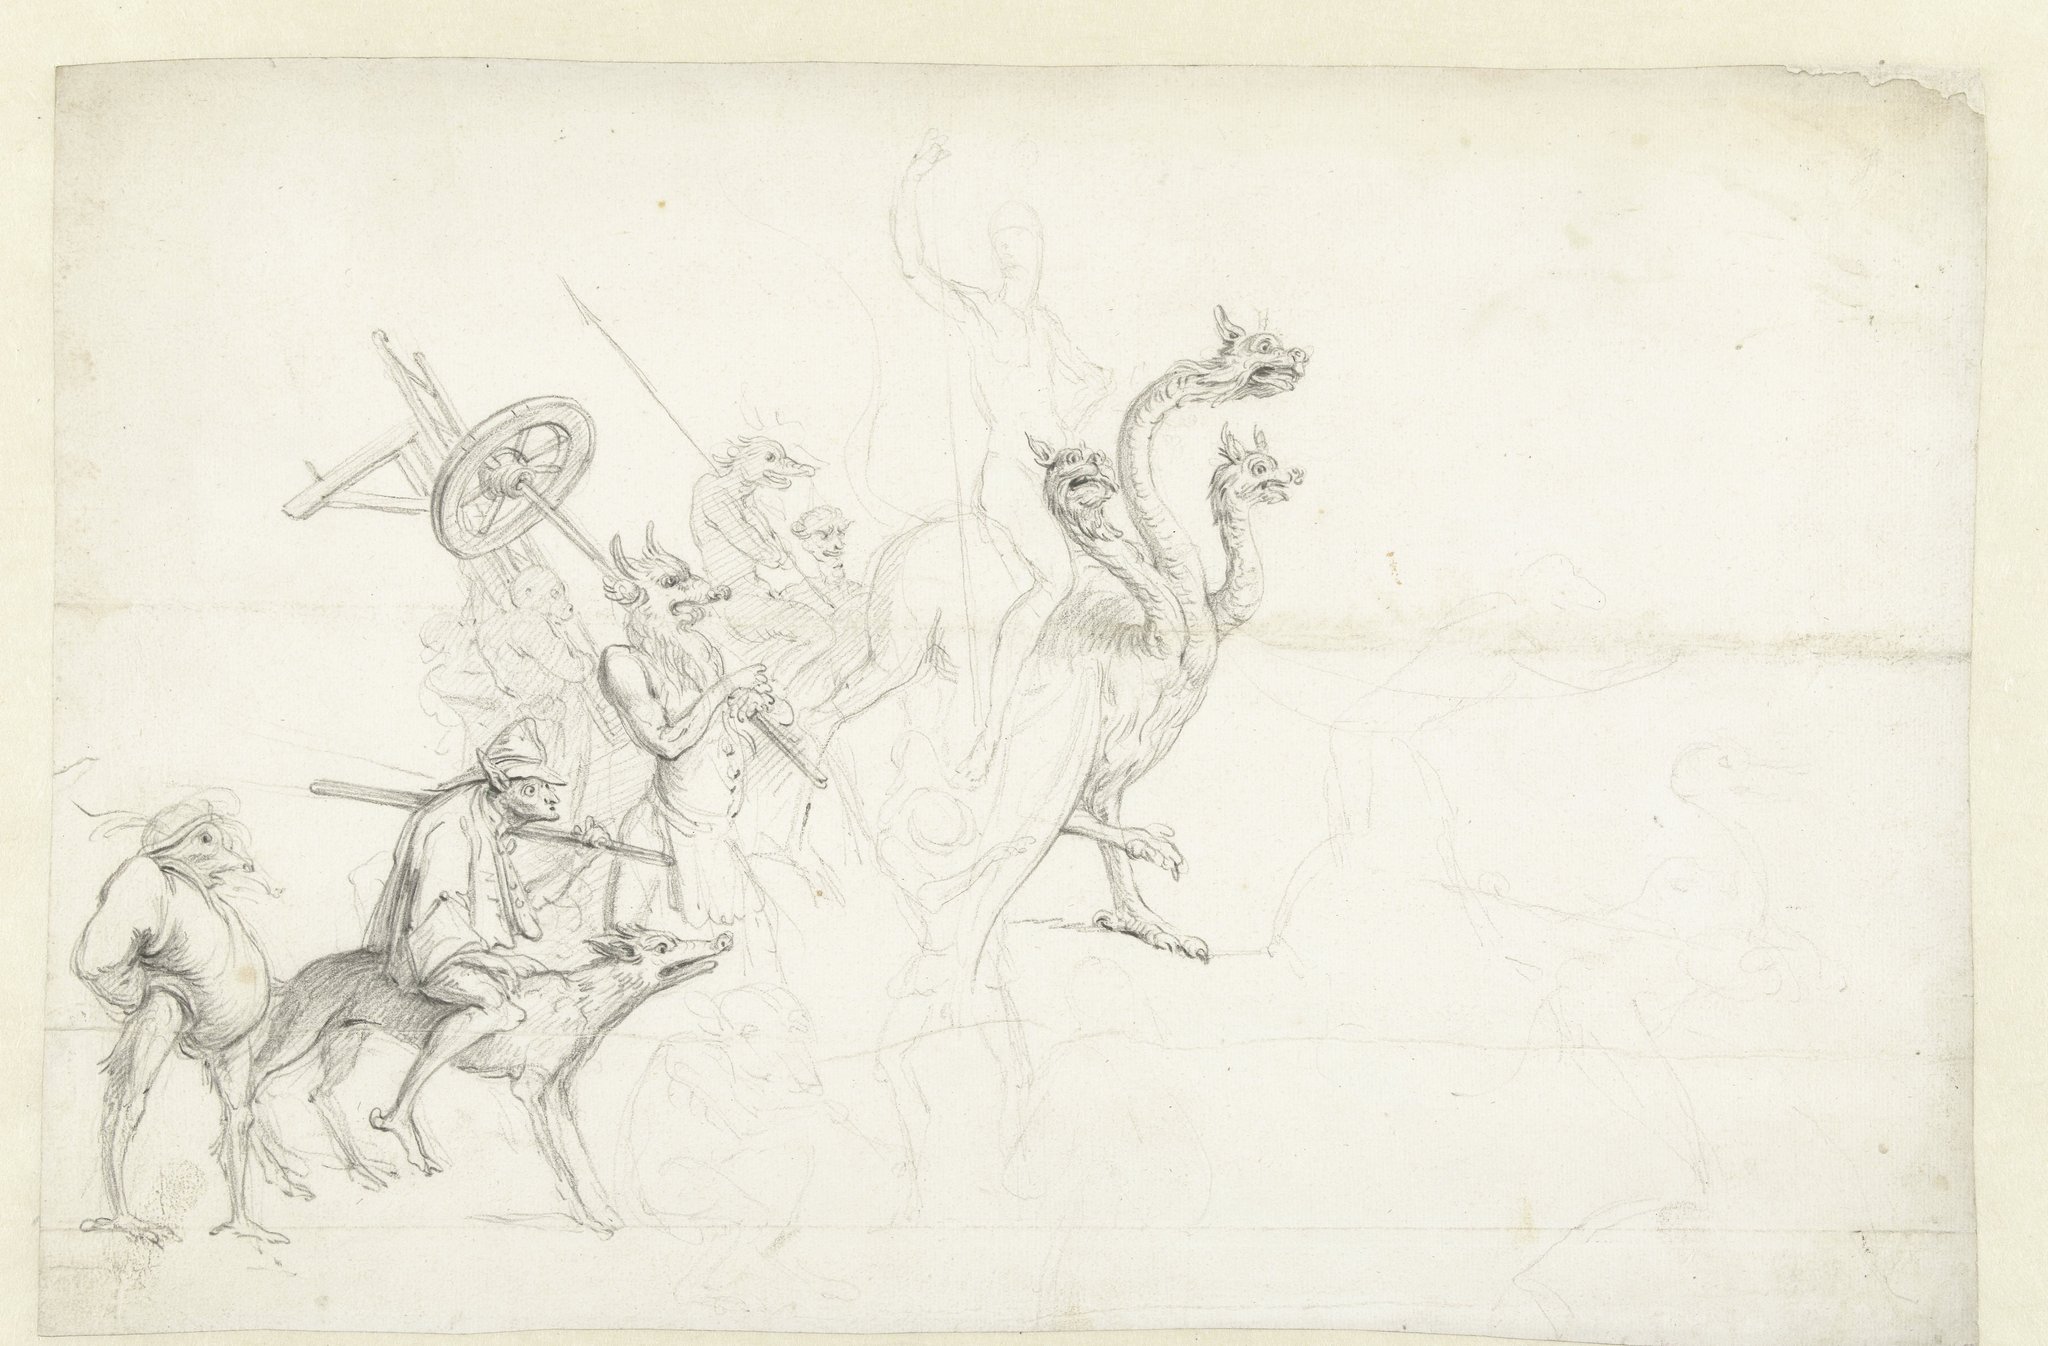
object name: drawing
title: Group of Imaginary Creatures, Turned to the Right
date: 1617-1681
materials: chalk, paper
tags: monsters of mixed human and animal shape; 'mostri' (ripa), violent death by hanging (+ instrument of execution), violent death by breaking on the wheel (+ instrument of execution)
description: Een groep fabelwezens van links opkomend, voorafgegaan door een driekoppig dier, waarop een krijgsman zit. Verder een staande duivel met een rad aan een as over de schouder en een bereden scharminkel op een soort hond.